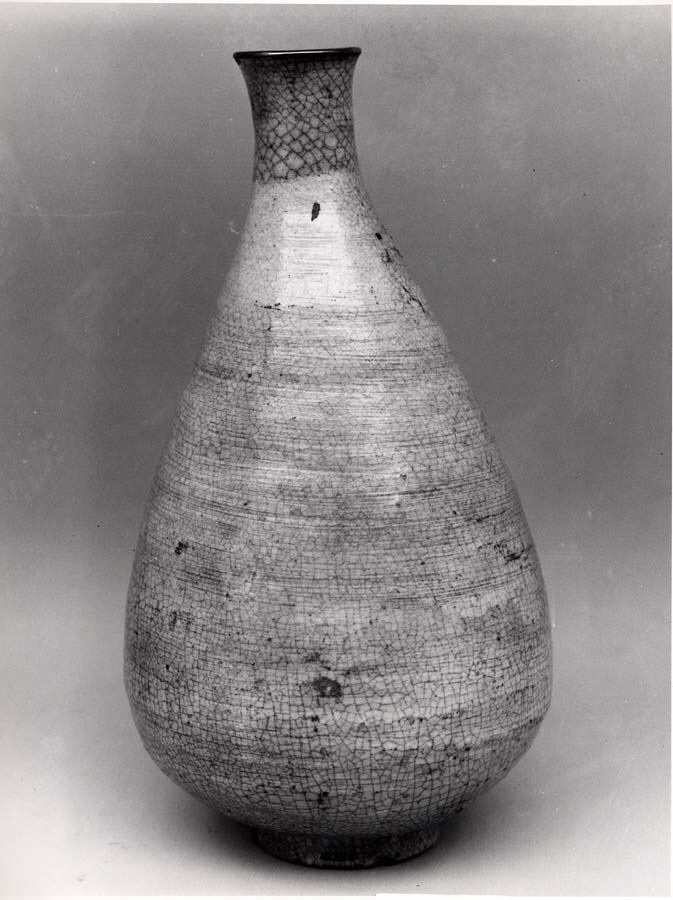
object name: vase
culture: korean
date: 1901-1933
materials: ceramic, glaze